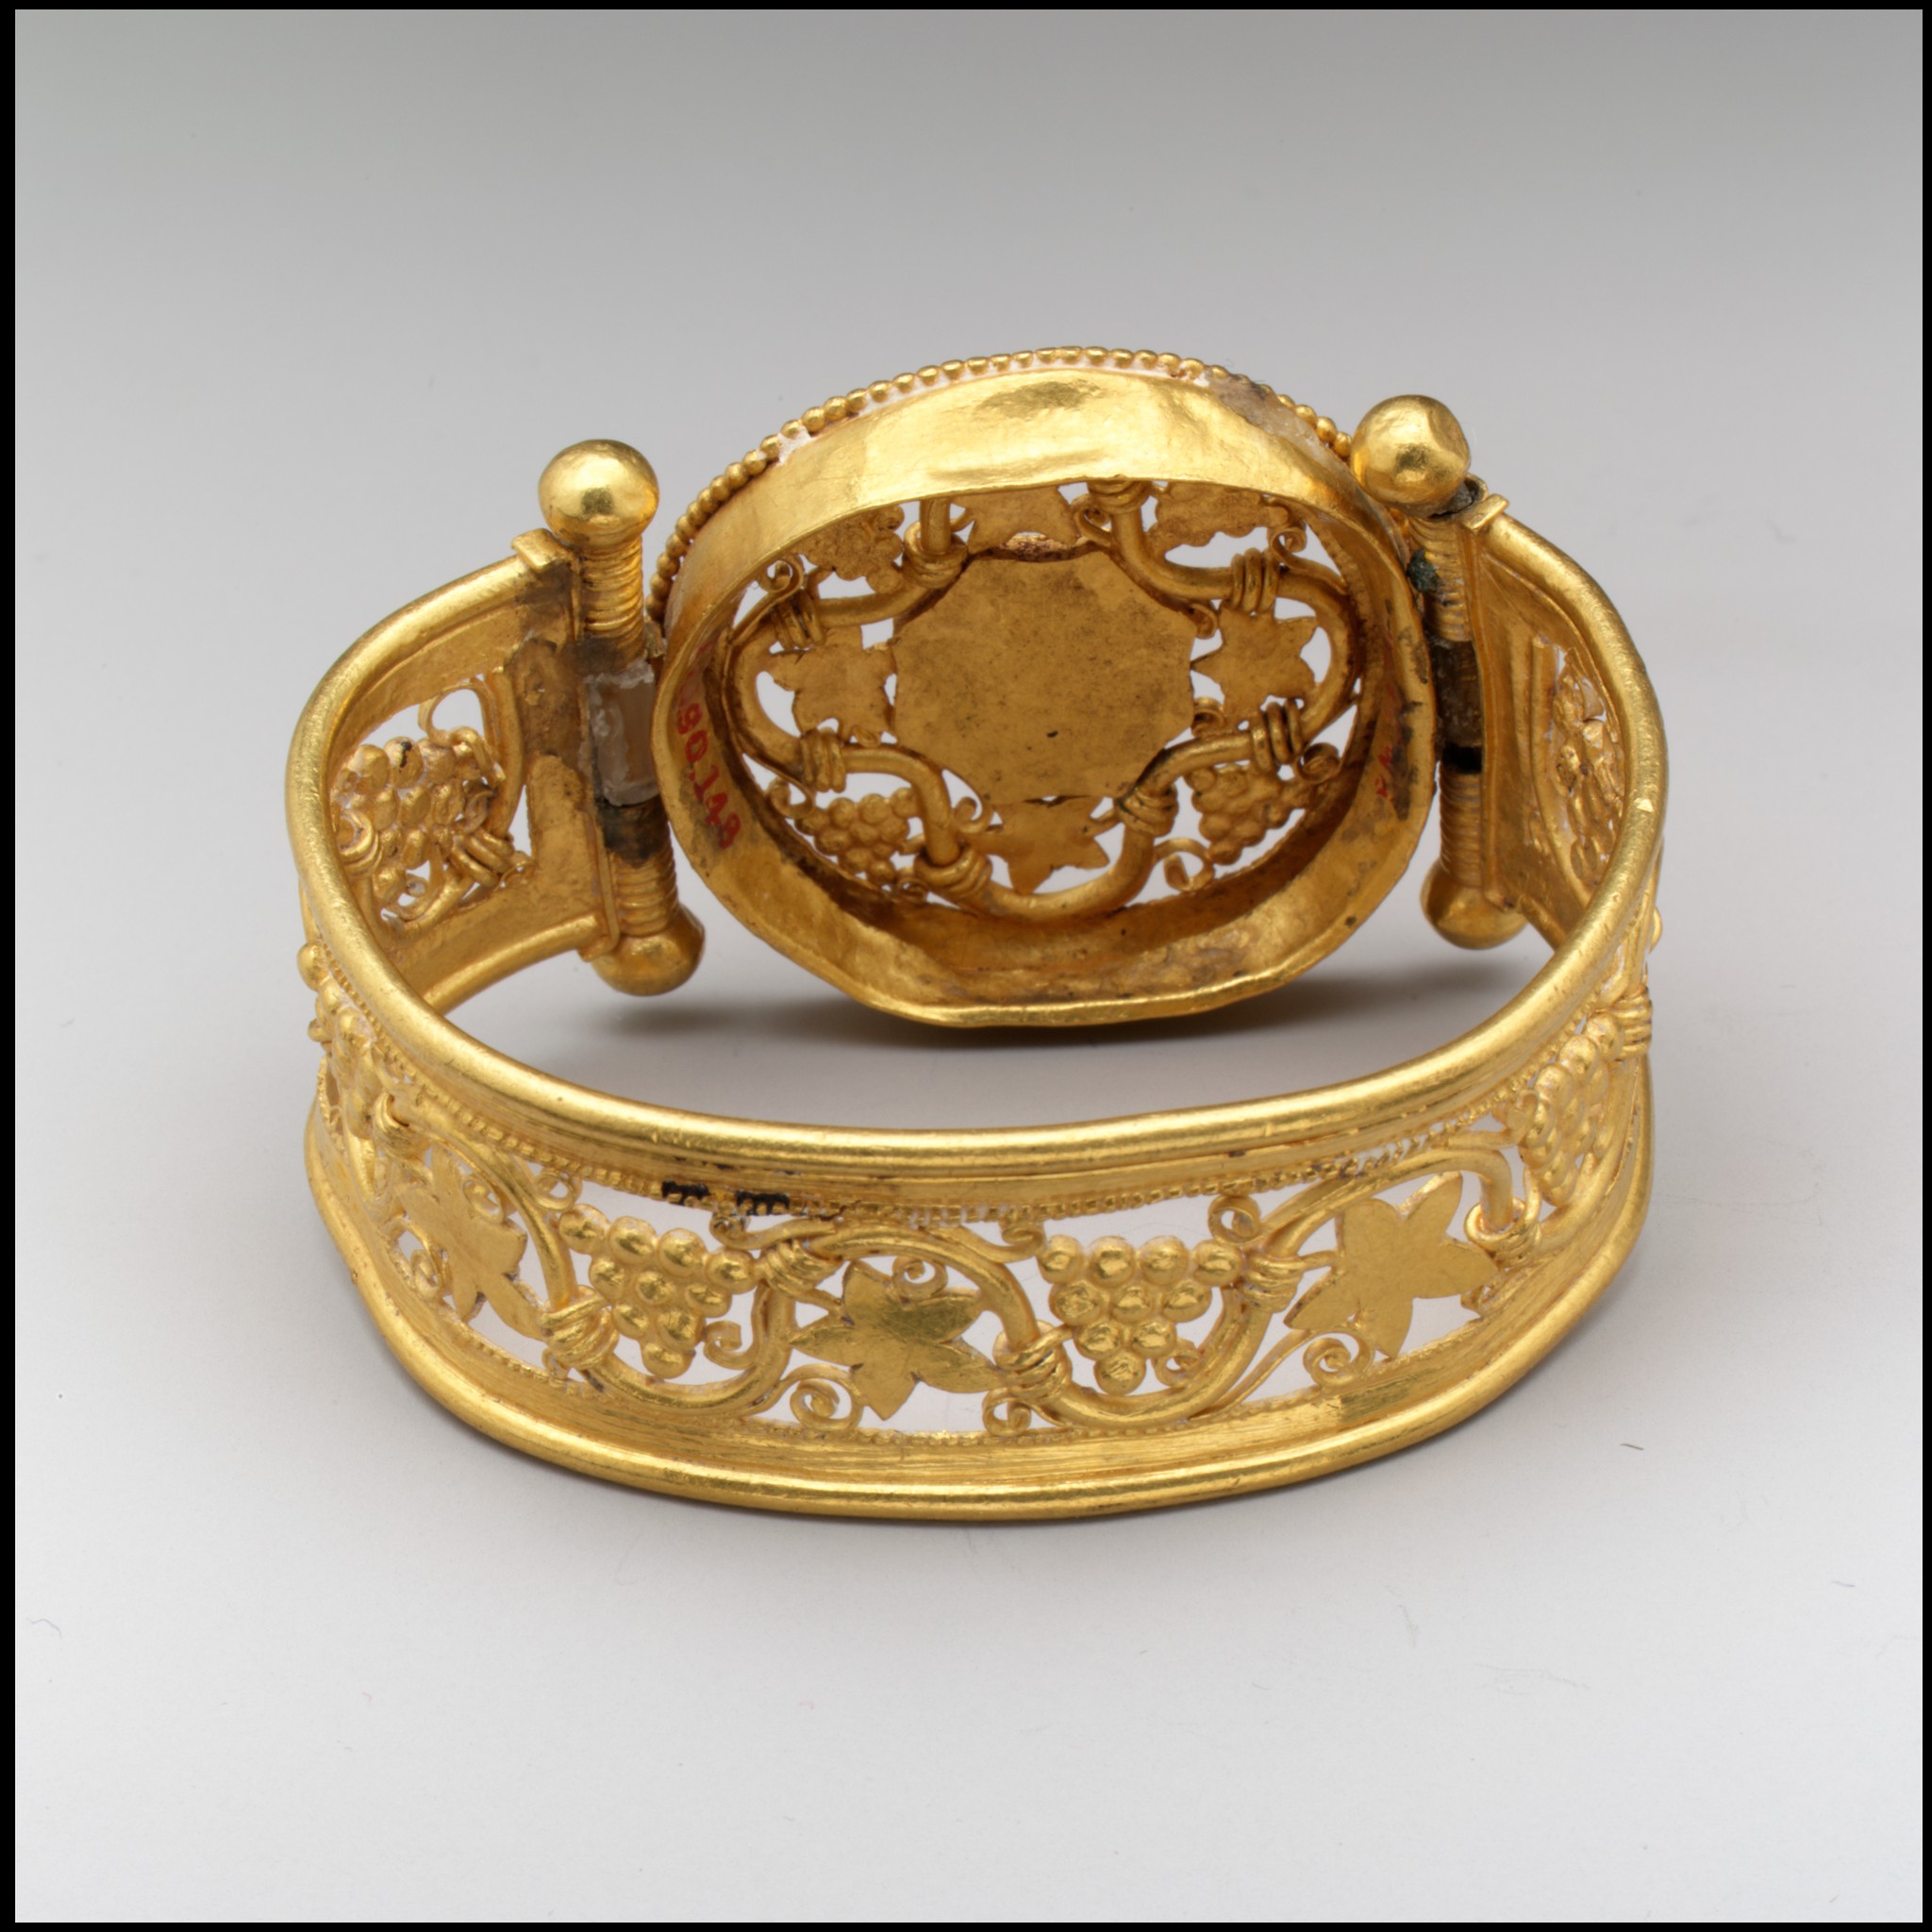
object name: bracelet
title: Bracelet with Grapevine Pattern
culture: byzantine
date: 567-633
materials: gold, metal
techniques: engraving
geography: possibly constantinople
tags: grapes,vines